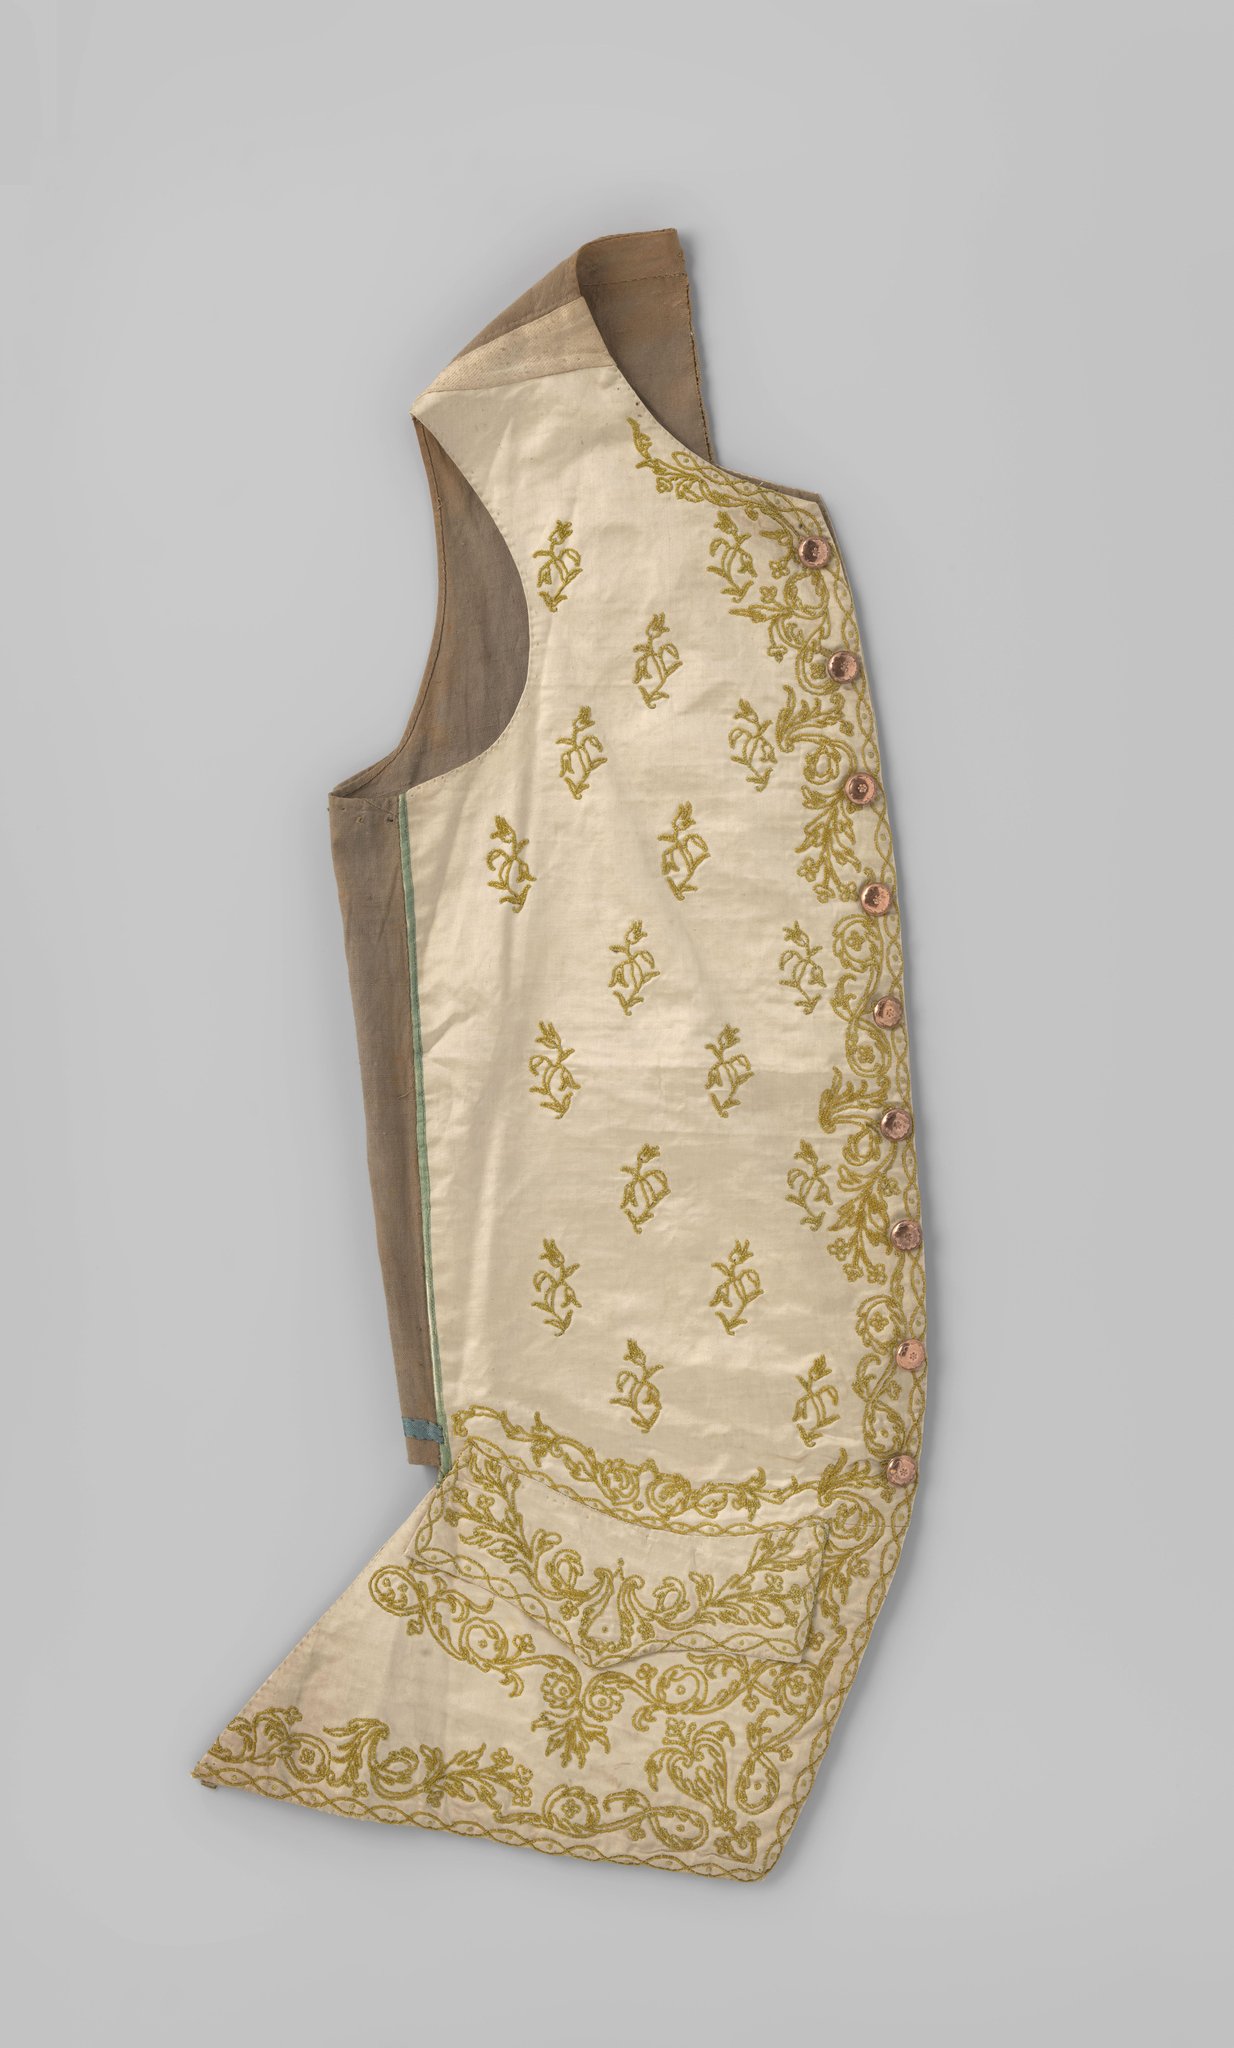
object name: main garment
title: Lang mouwloos vest met 9 koperen knopen met bloem, van crème satijn, in felgroen en chenille geborduurd met floraal strooi- en randmotief en quilloche; linnen voering en rug.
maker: Anonymous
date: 1740-1750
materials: textile, copper, linen, silk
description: Vest van wit satijn met groene chenille slingers. Rood koperen knopen. Geen kraag. Rugsplit met blauwe bandsluiting.